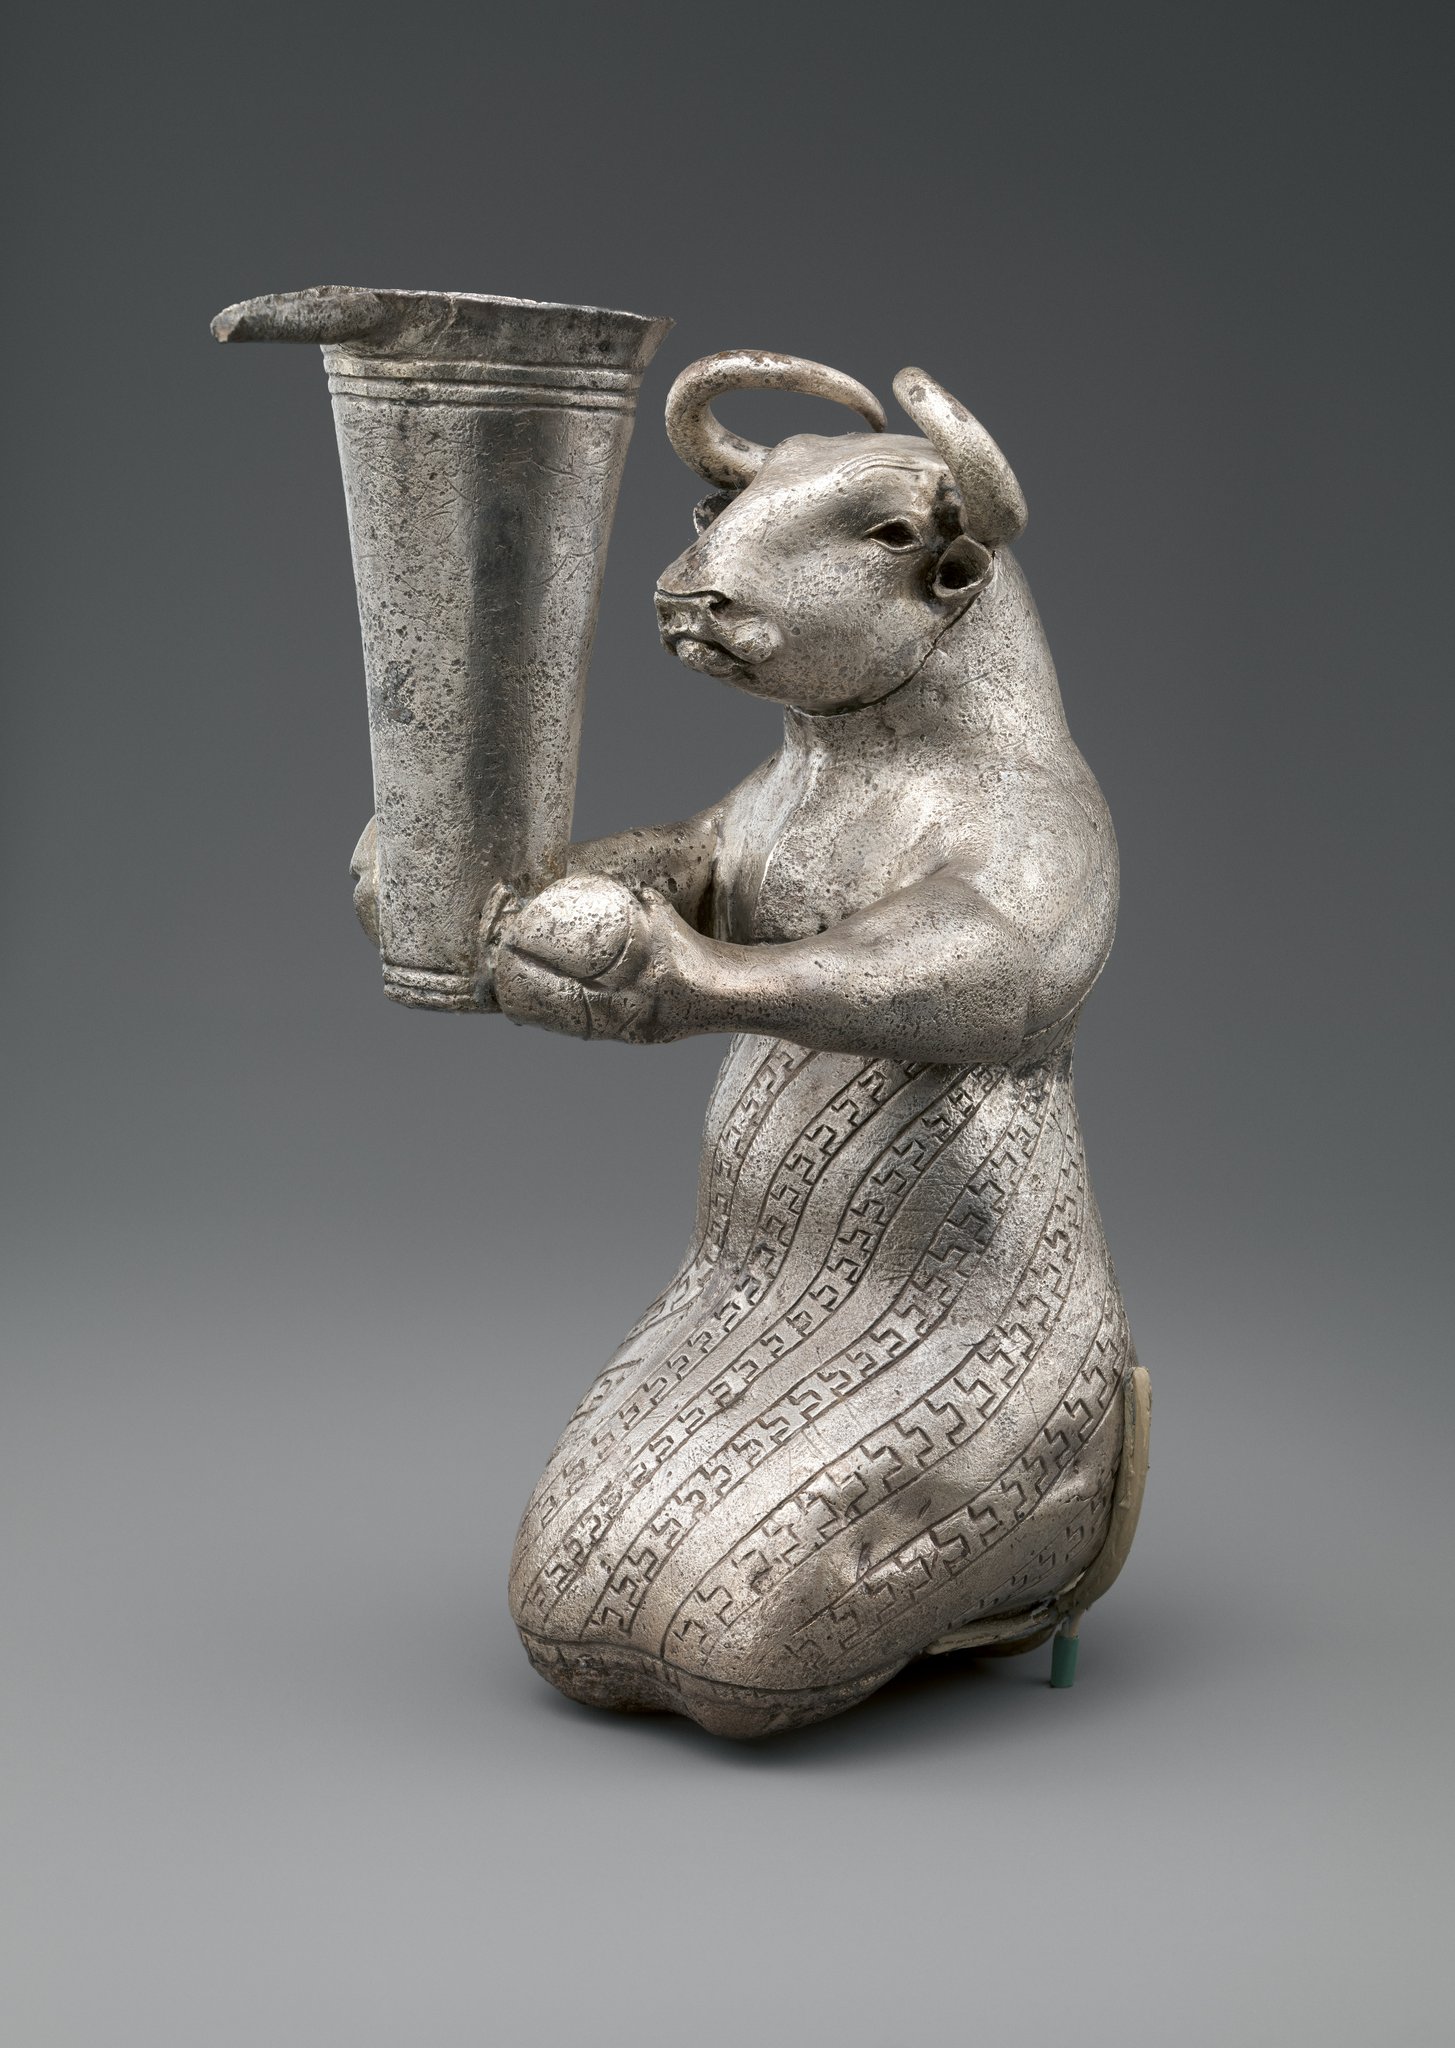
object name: sculpture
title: Kneeling bull holding a spouted vessel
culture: proto-elamite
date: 3100-2900 BCE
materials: silver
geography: iran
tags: bulls